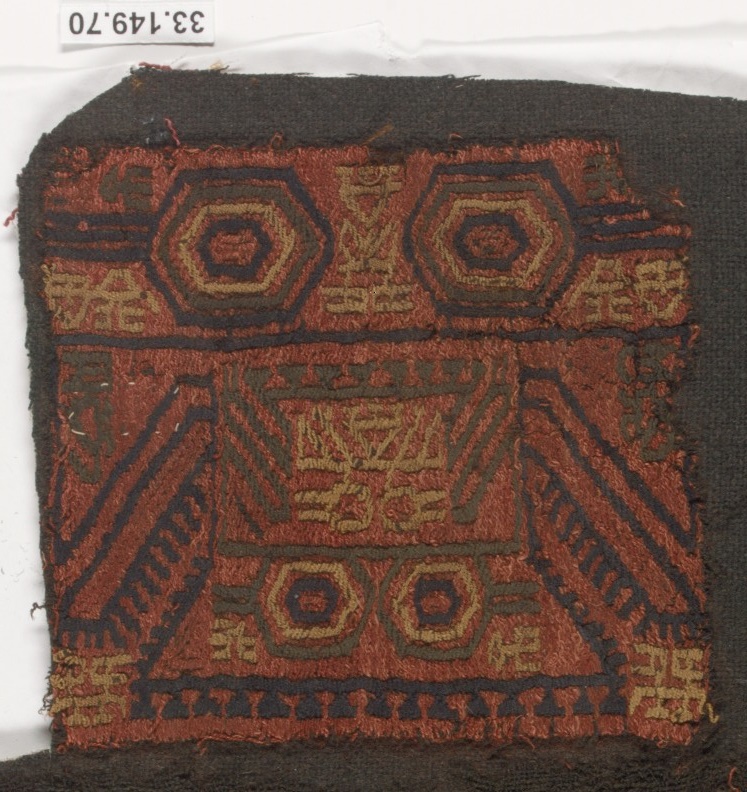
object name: textile fragment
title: Embroidered Fragment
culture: paracas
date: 500-101 BCE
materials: animal fiber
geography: peru